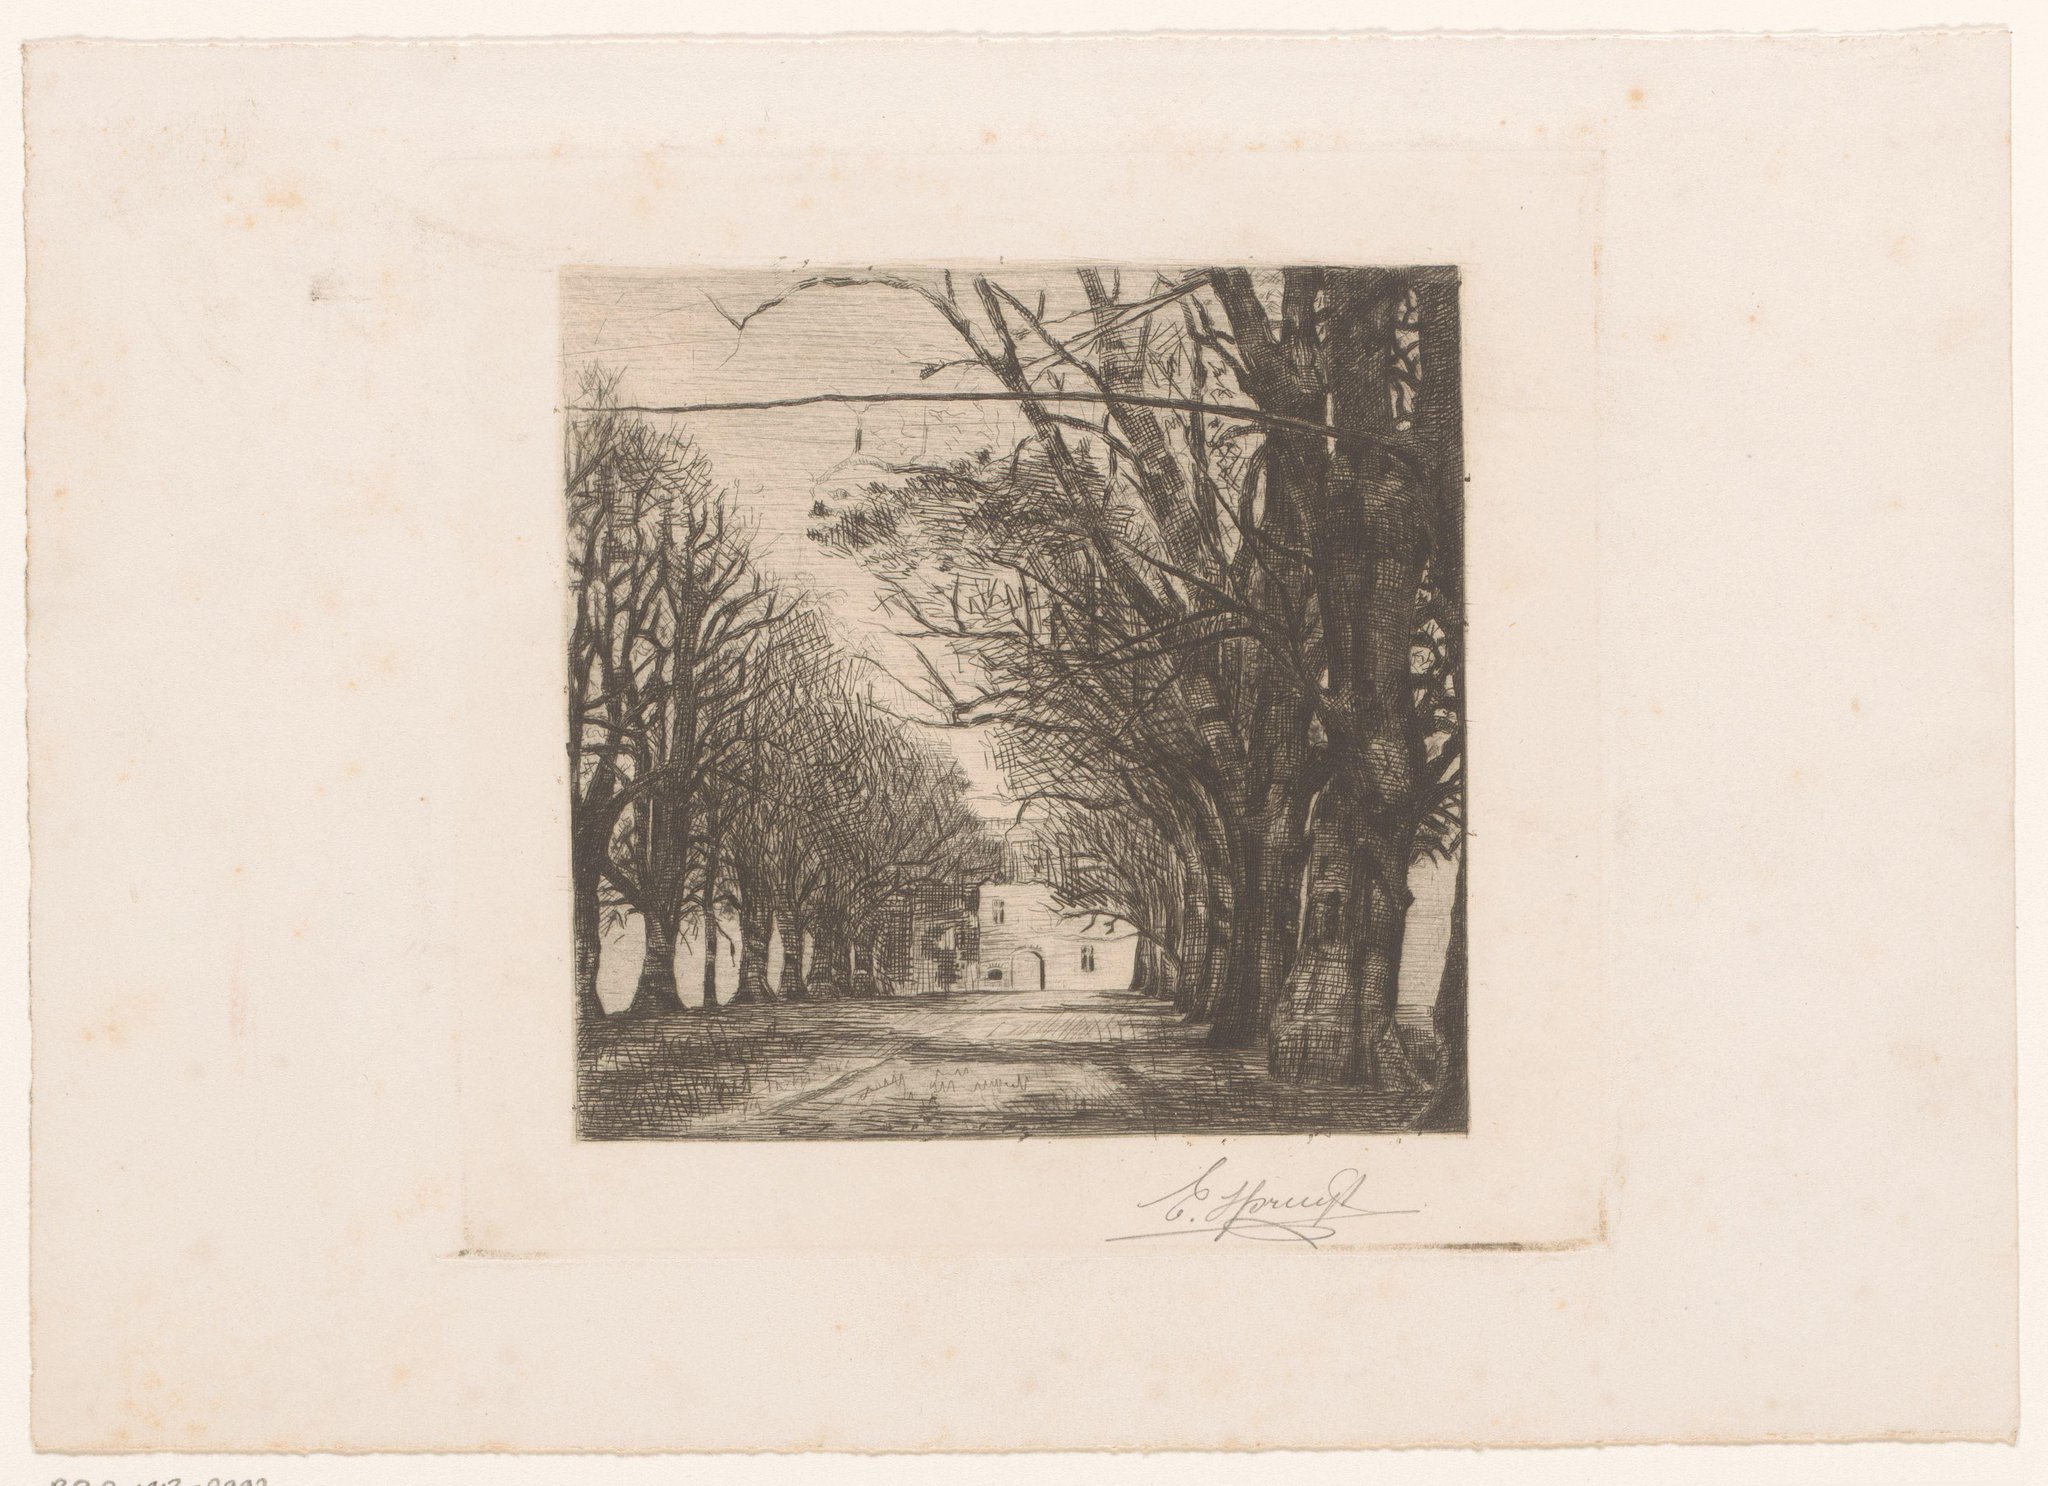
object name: print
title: Laan met bomen uitkomend op een gebouw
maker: emile pierre maria spruyt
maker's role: print maker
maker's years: 1870-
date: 1880-1913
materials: paper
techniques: etching, intaglio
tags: lane, alley, trees (+ plants used symbolically)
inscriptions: collector's mark: Lugt 2228